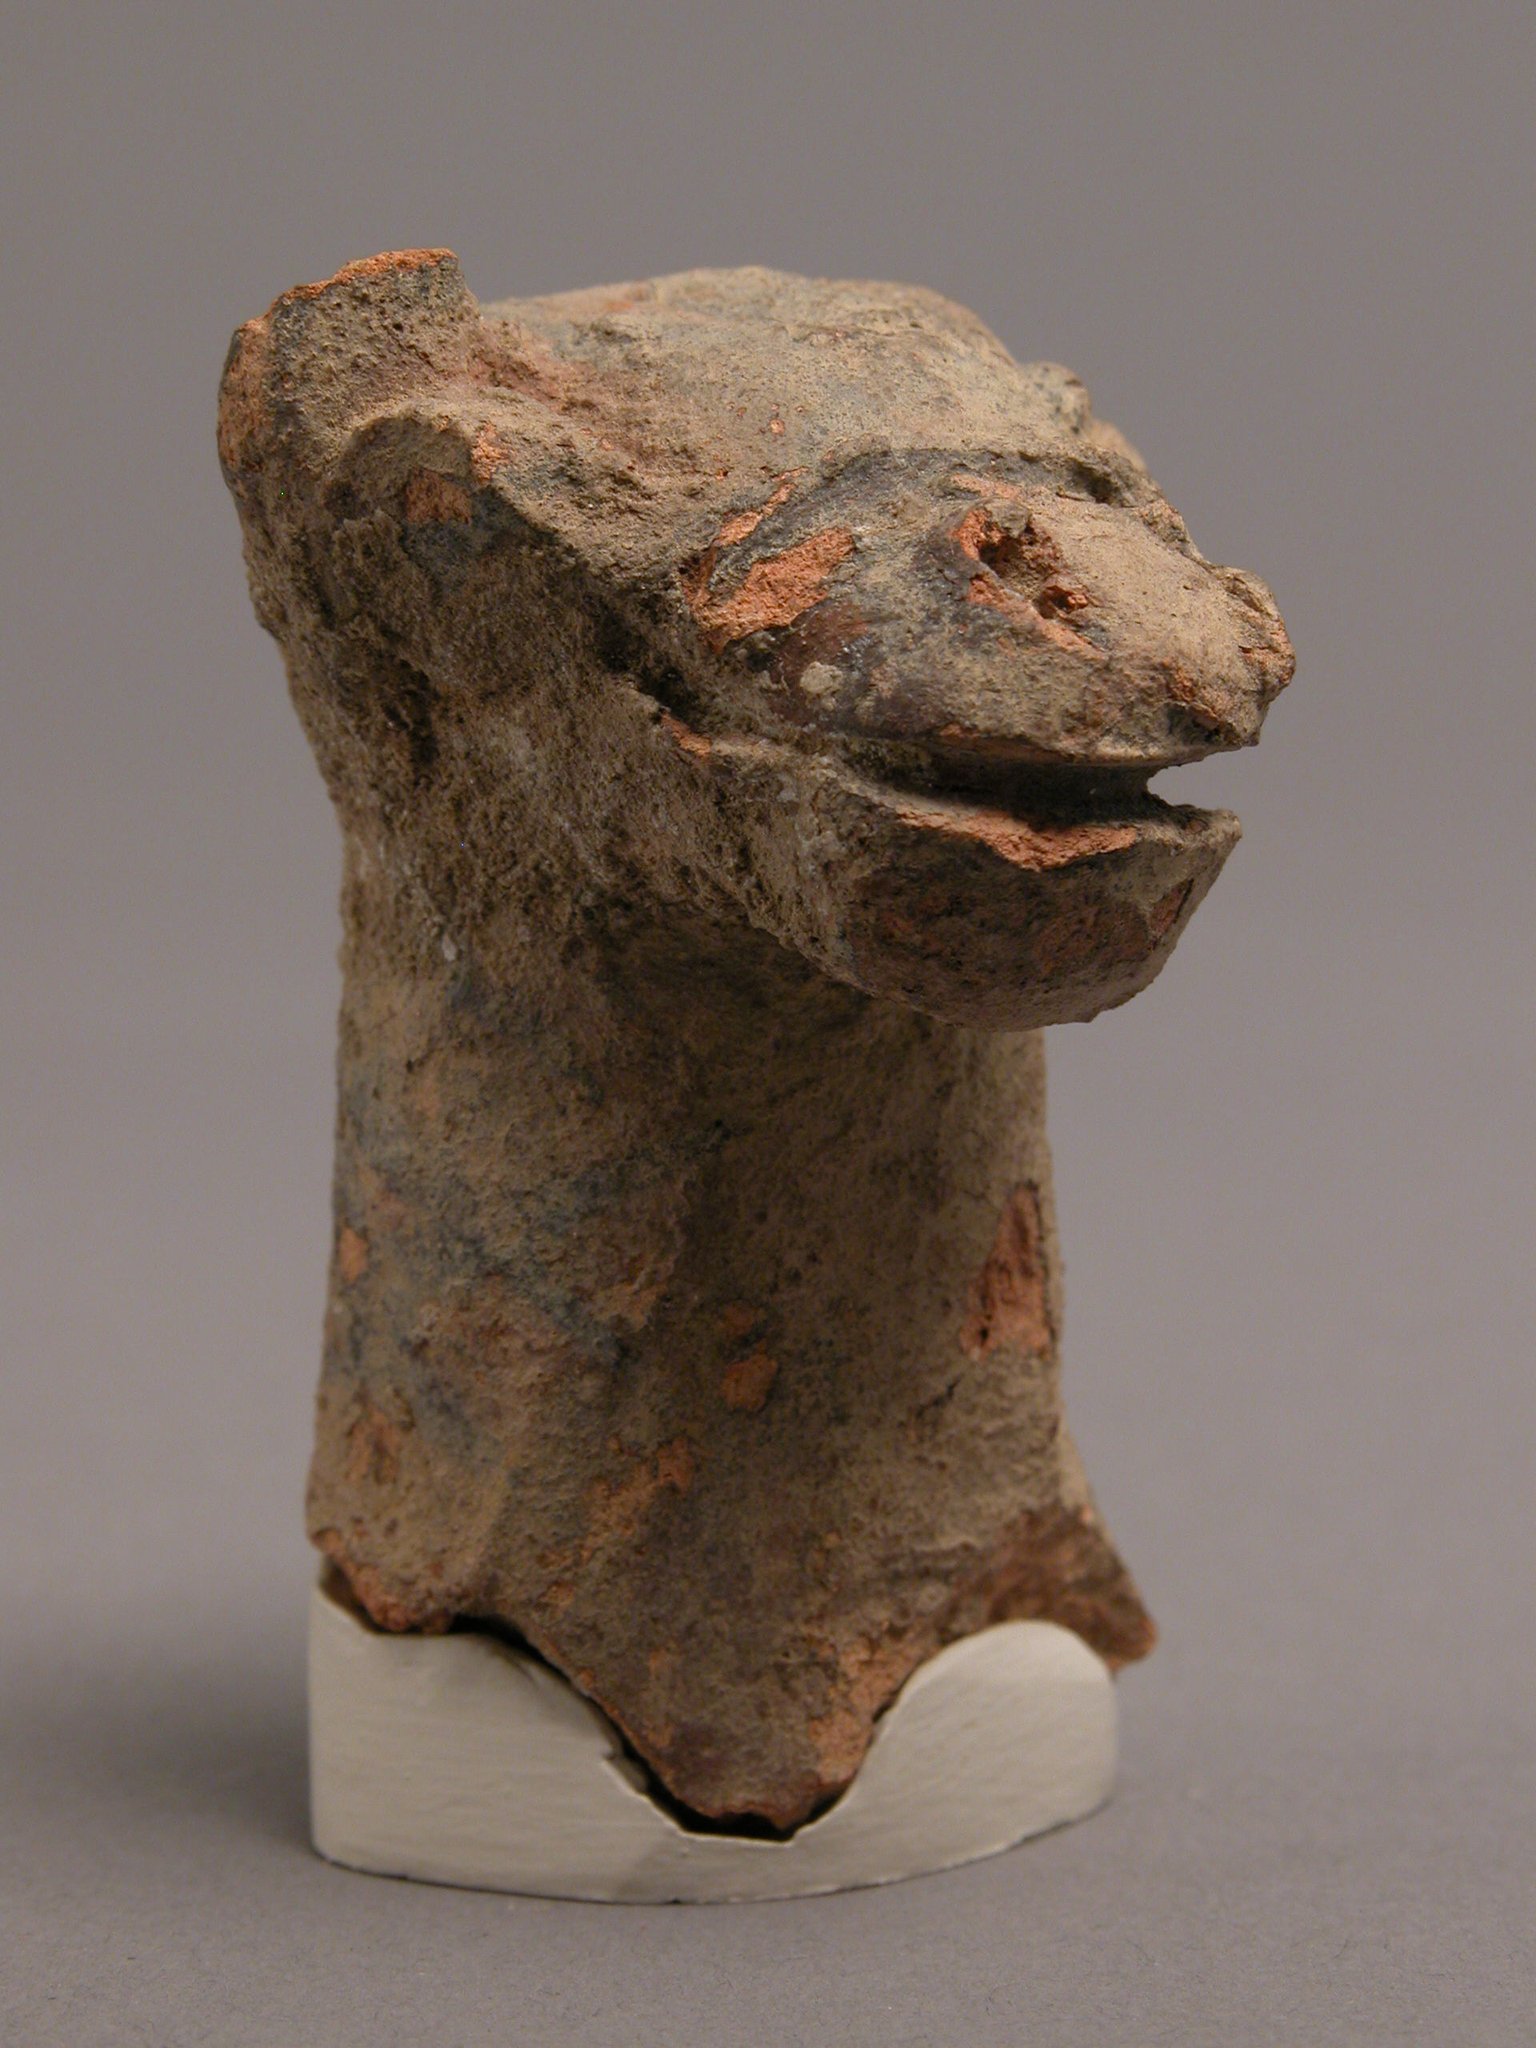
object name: statuette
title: Head of Camel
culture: coptic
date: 301-700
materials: earthenware, pigment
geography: egypt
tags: camels